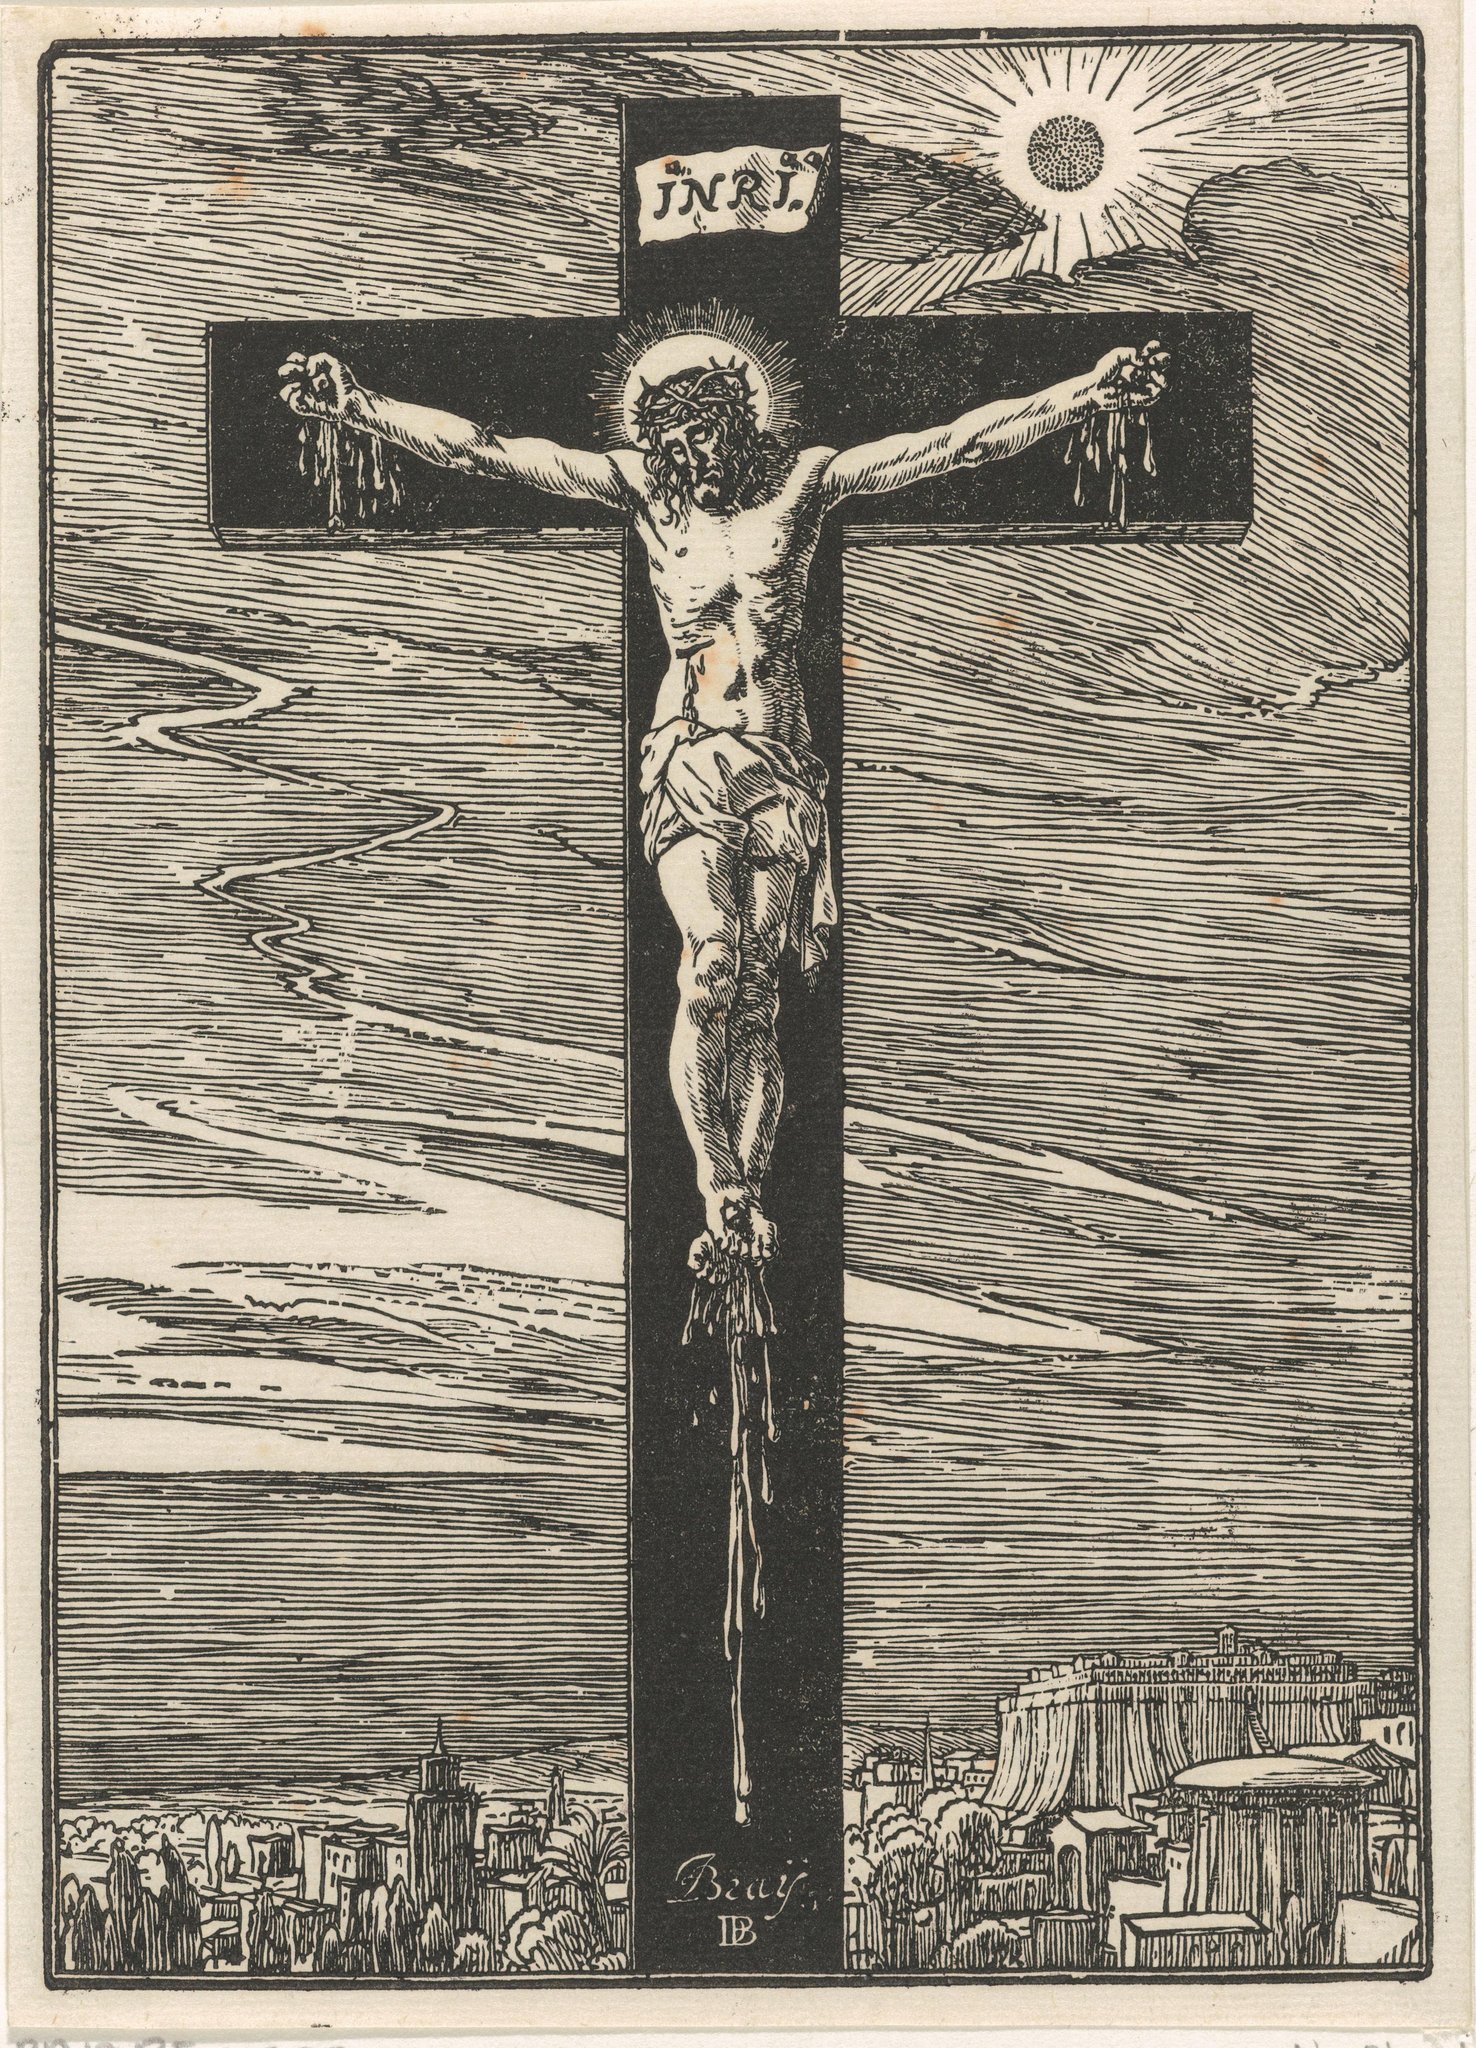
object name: print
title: Christus aan het kruis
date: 1635-1694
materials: paper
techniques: woodcut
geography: netherlands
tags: the crucifixion of christ: christ's death on the cross; golgotha (matthew 27:45-58; mark 15:33-45; luke 23:44-52; john 19:25-38)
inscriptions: collector's mark: Lugt 2228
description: Lange bloedvlekken benadrukken de verwondingen aan zijn handen en voeten. Op de achtergrond de stad Jeruzalem.